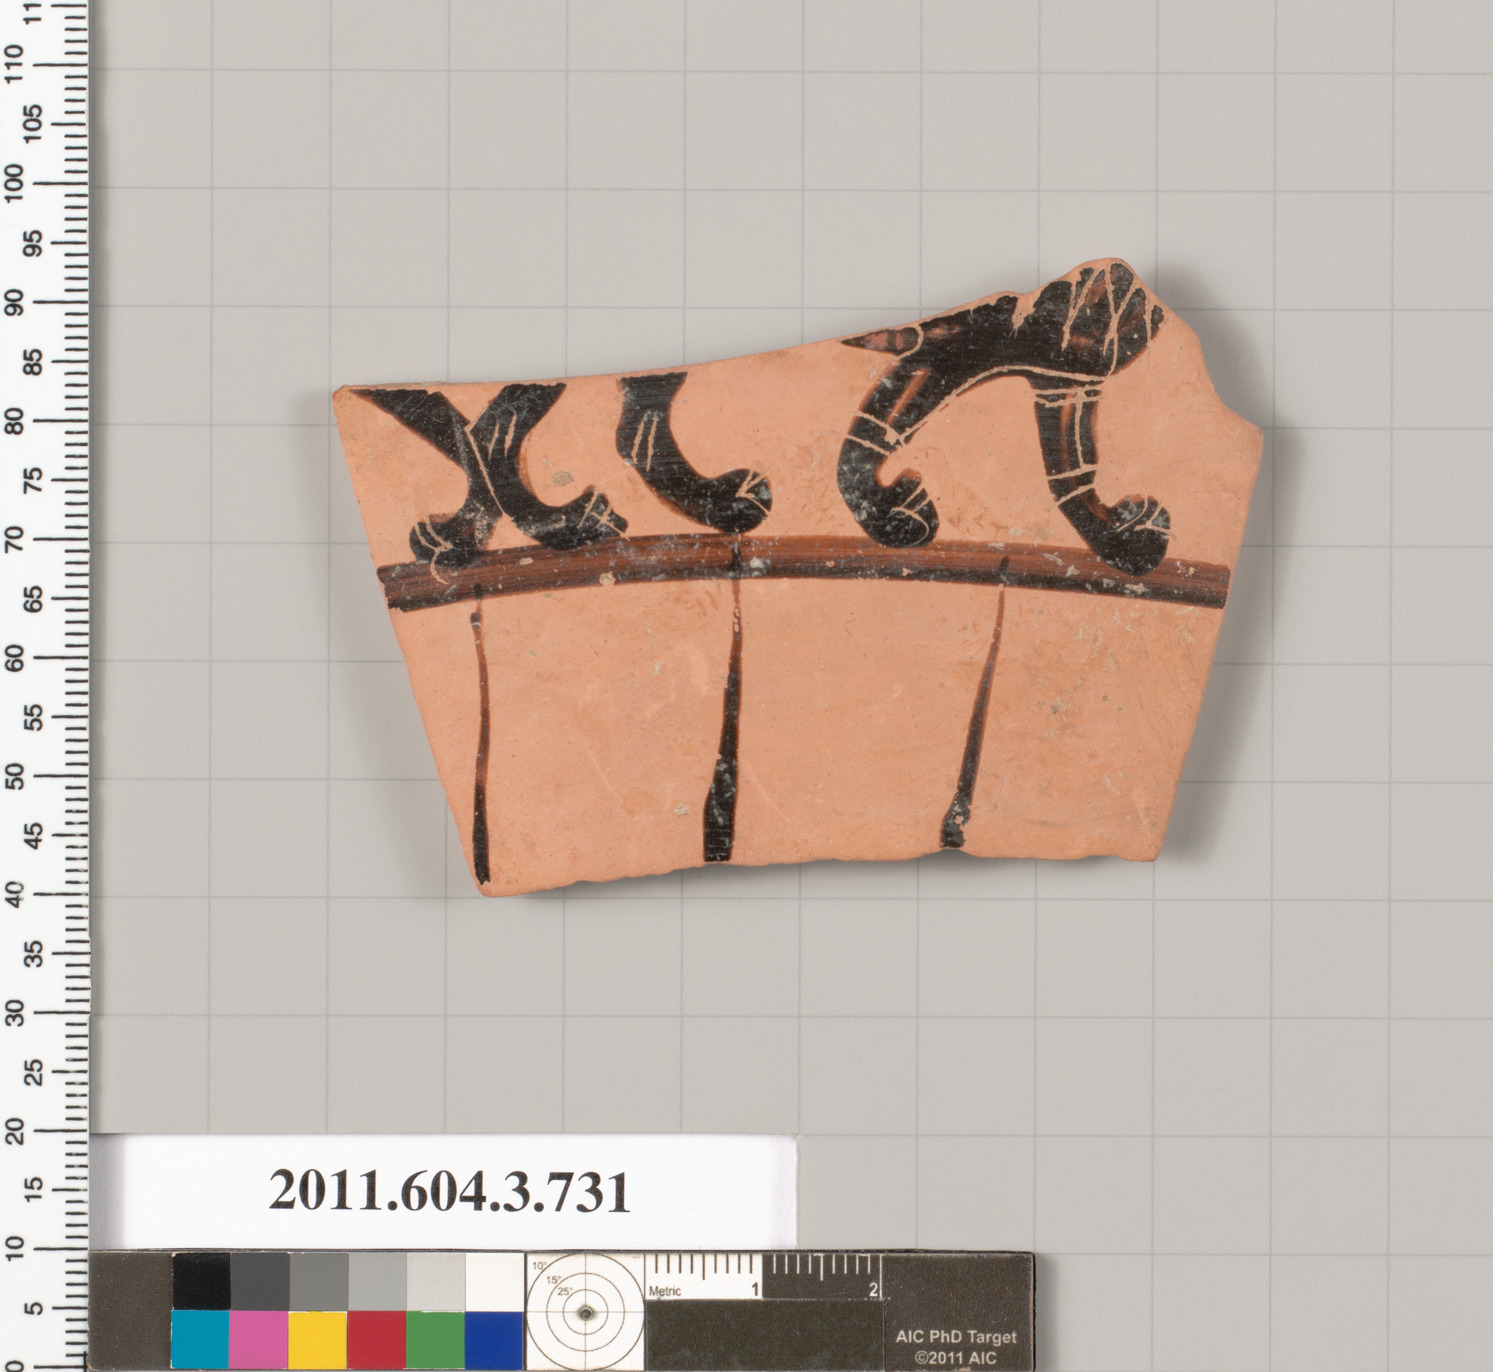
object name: neck amphora, tyrrhenian fragment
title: Terracotta fragment of a neck-amphora (jar)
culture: greek, attic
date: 575-551 BCE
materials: terracotta